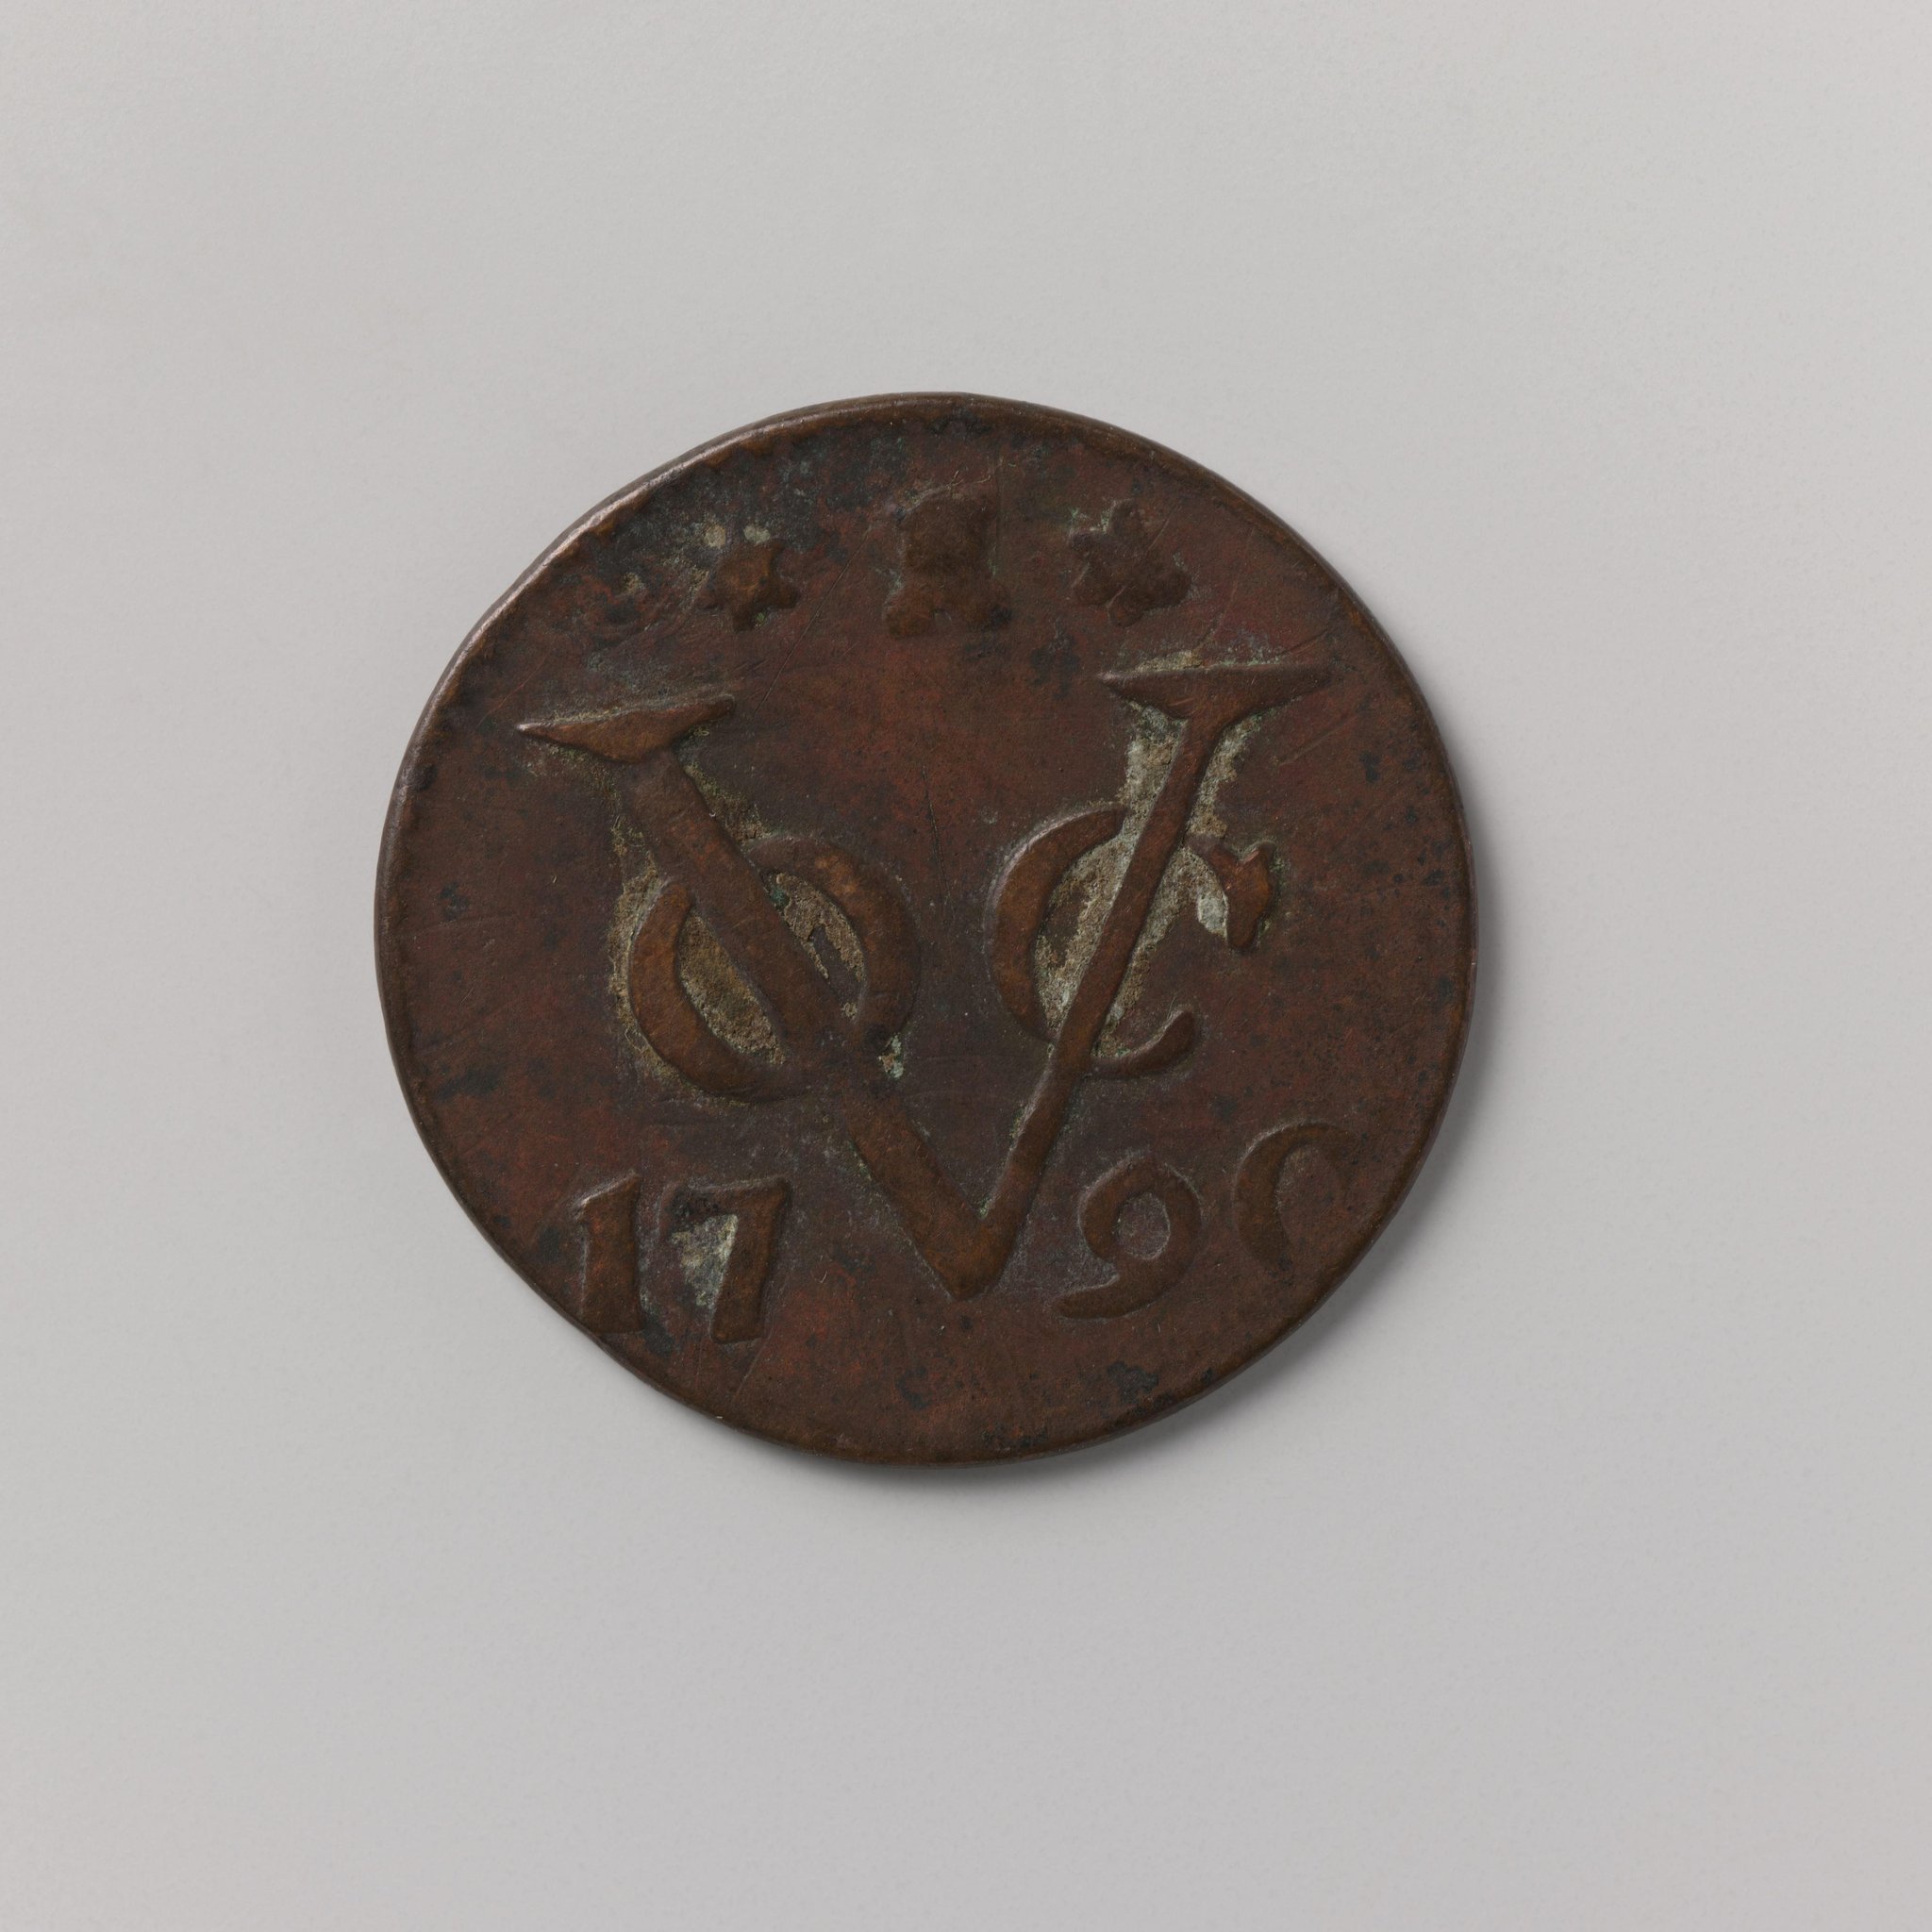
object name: coin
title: VOC, duit Zeeland, 1790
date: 1790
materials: copper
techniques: striking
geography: middelburg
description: Koperen munt. Voorzijde: gekroond wapenschild van Zeeland. Keerzijde: monogram van de VOC, waarboven muntteken en waaronder jaartal. Gladde rand.